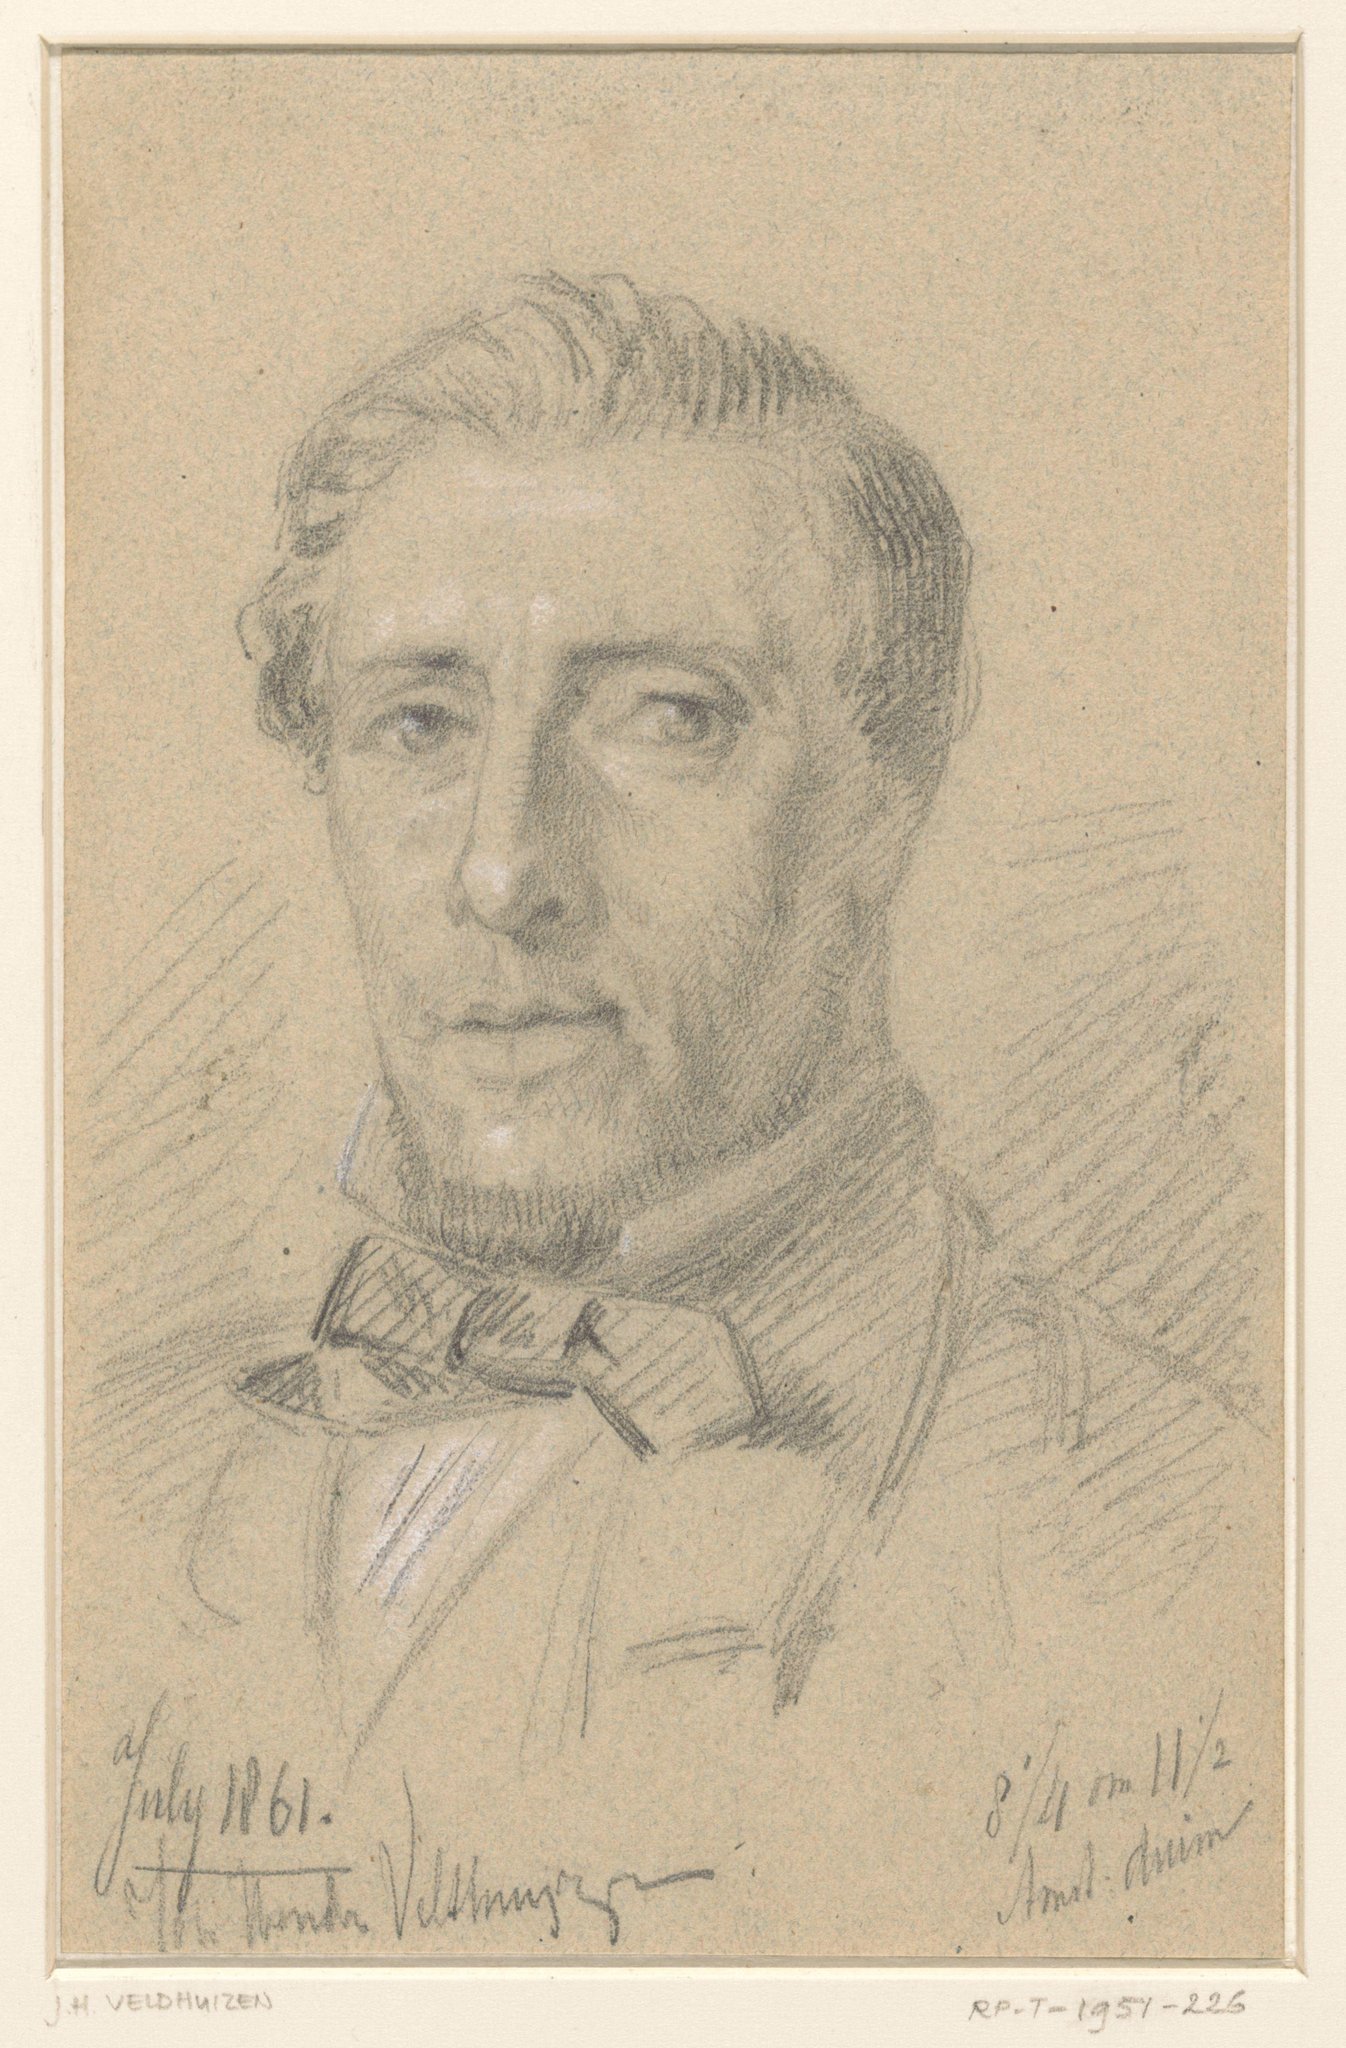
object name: drawing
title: Portret van een man met een vlinderdasje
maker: johannes hendrik veldhuijzen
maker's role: draughtsman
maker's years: 1831-1910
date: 1807-1861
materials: paper, pencil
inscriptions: date: ‘July 1861’